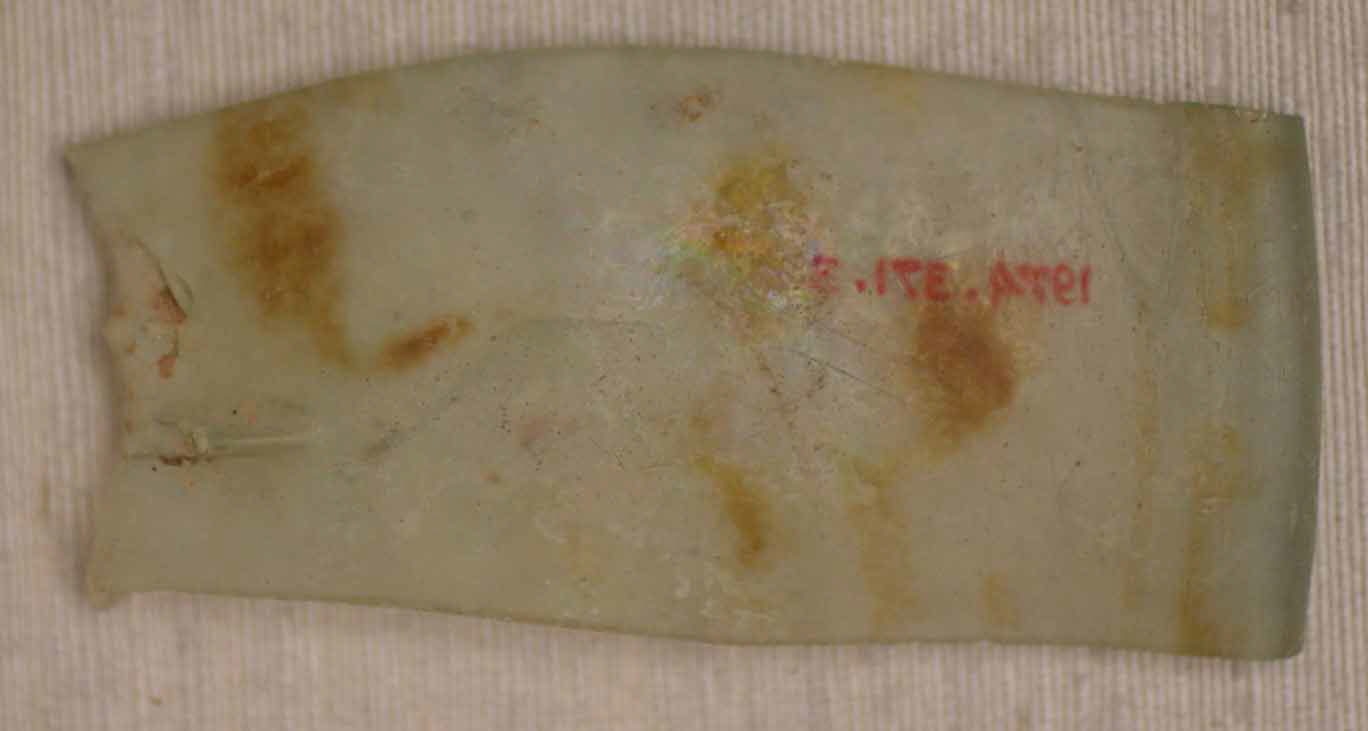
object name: fragment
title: Glass Fragment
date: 801-900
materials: glass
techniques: luster painting, stain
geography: egypt or iraq